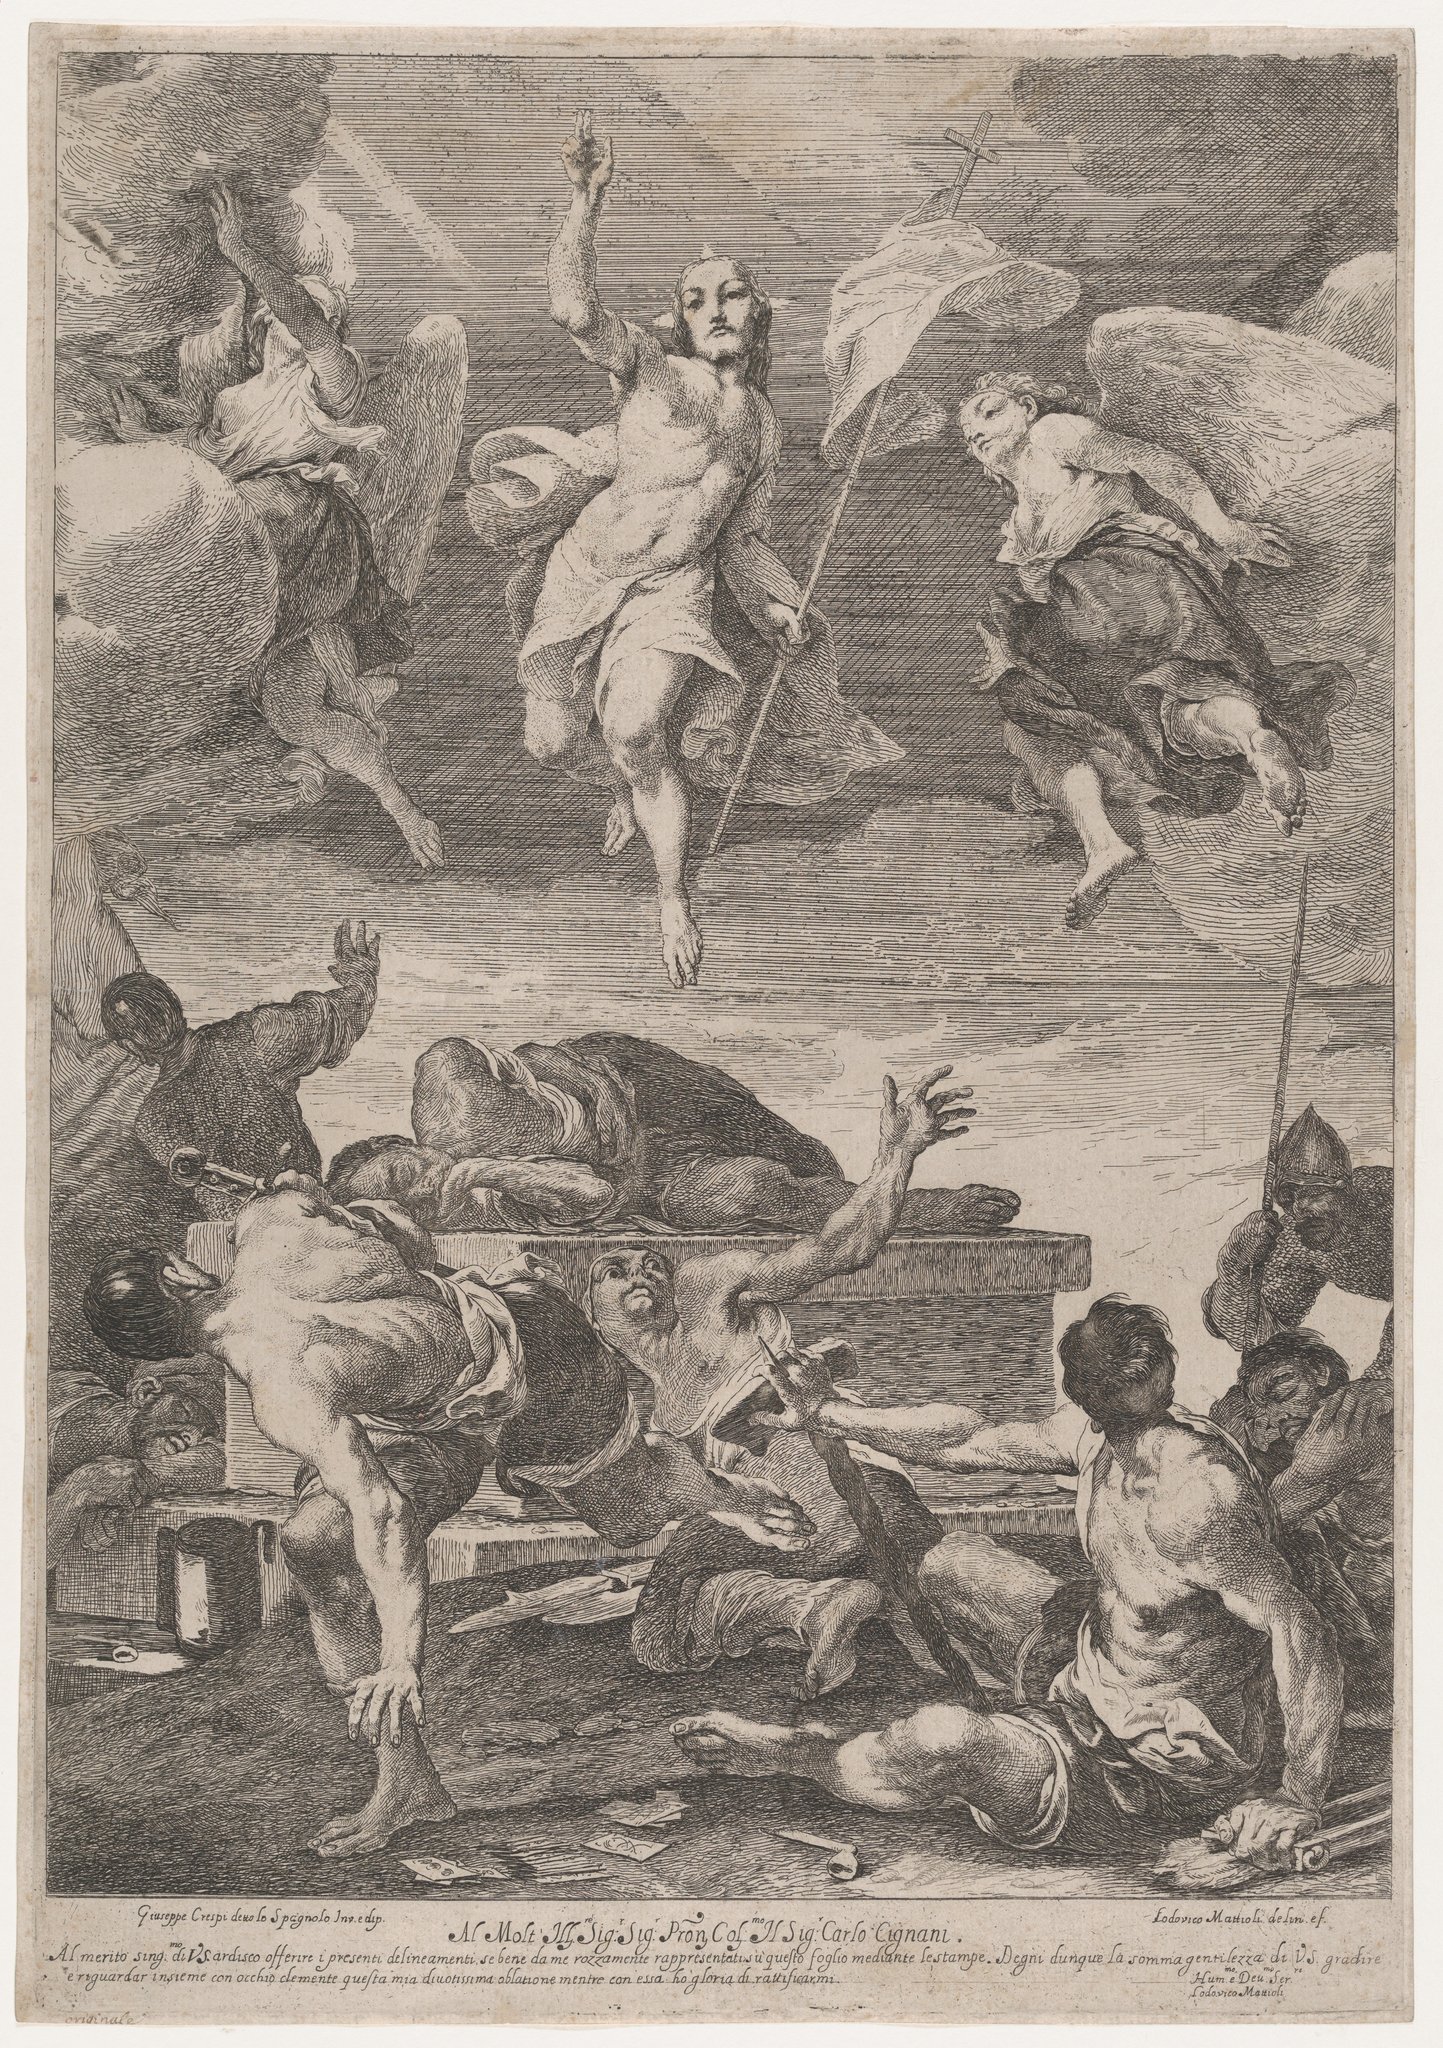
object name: print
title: The Resurrection of Christ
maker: lodovico mattioli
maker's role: artist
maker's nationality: italian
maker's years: 1662-1747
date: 1700-1740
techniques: etching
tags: men,angels,christ